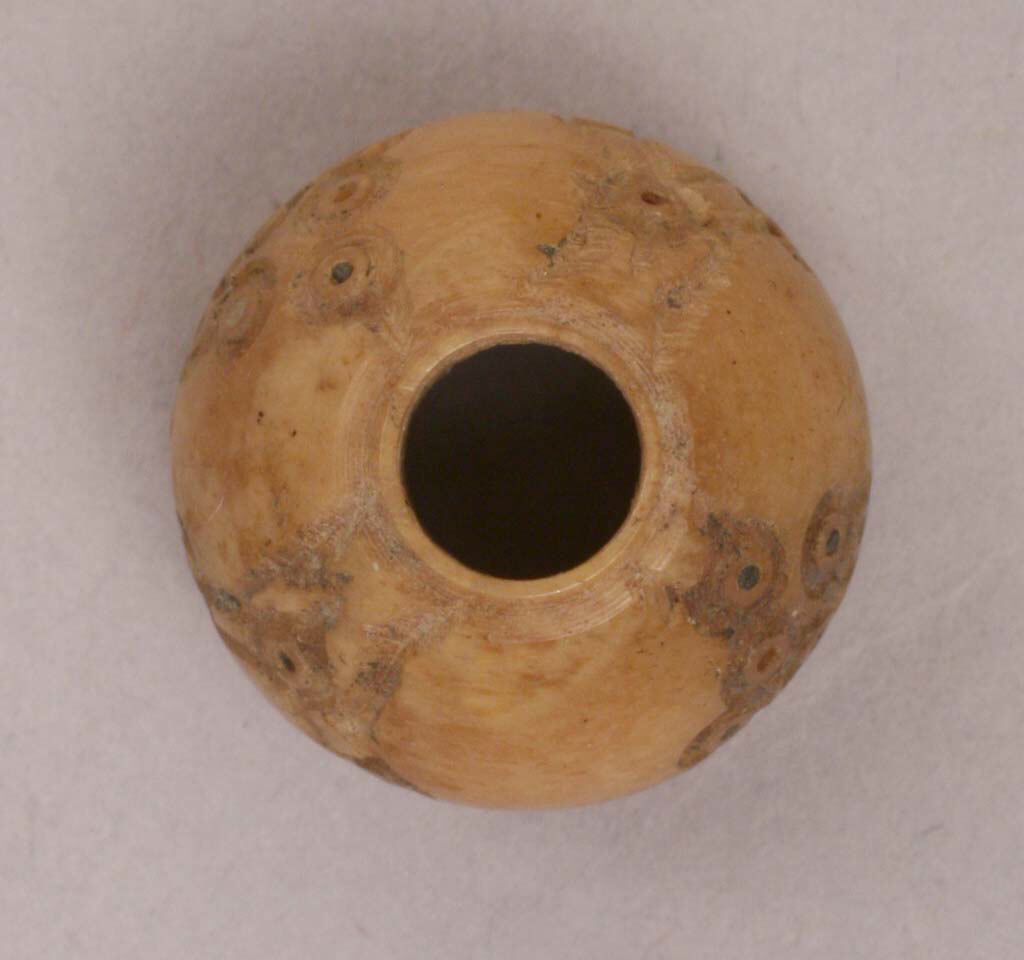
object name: button or bead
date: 801-1000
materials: bone, ivory, paint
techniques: incising, inlay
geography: iran